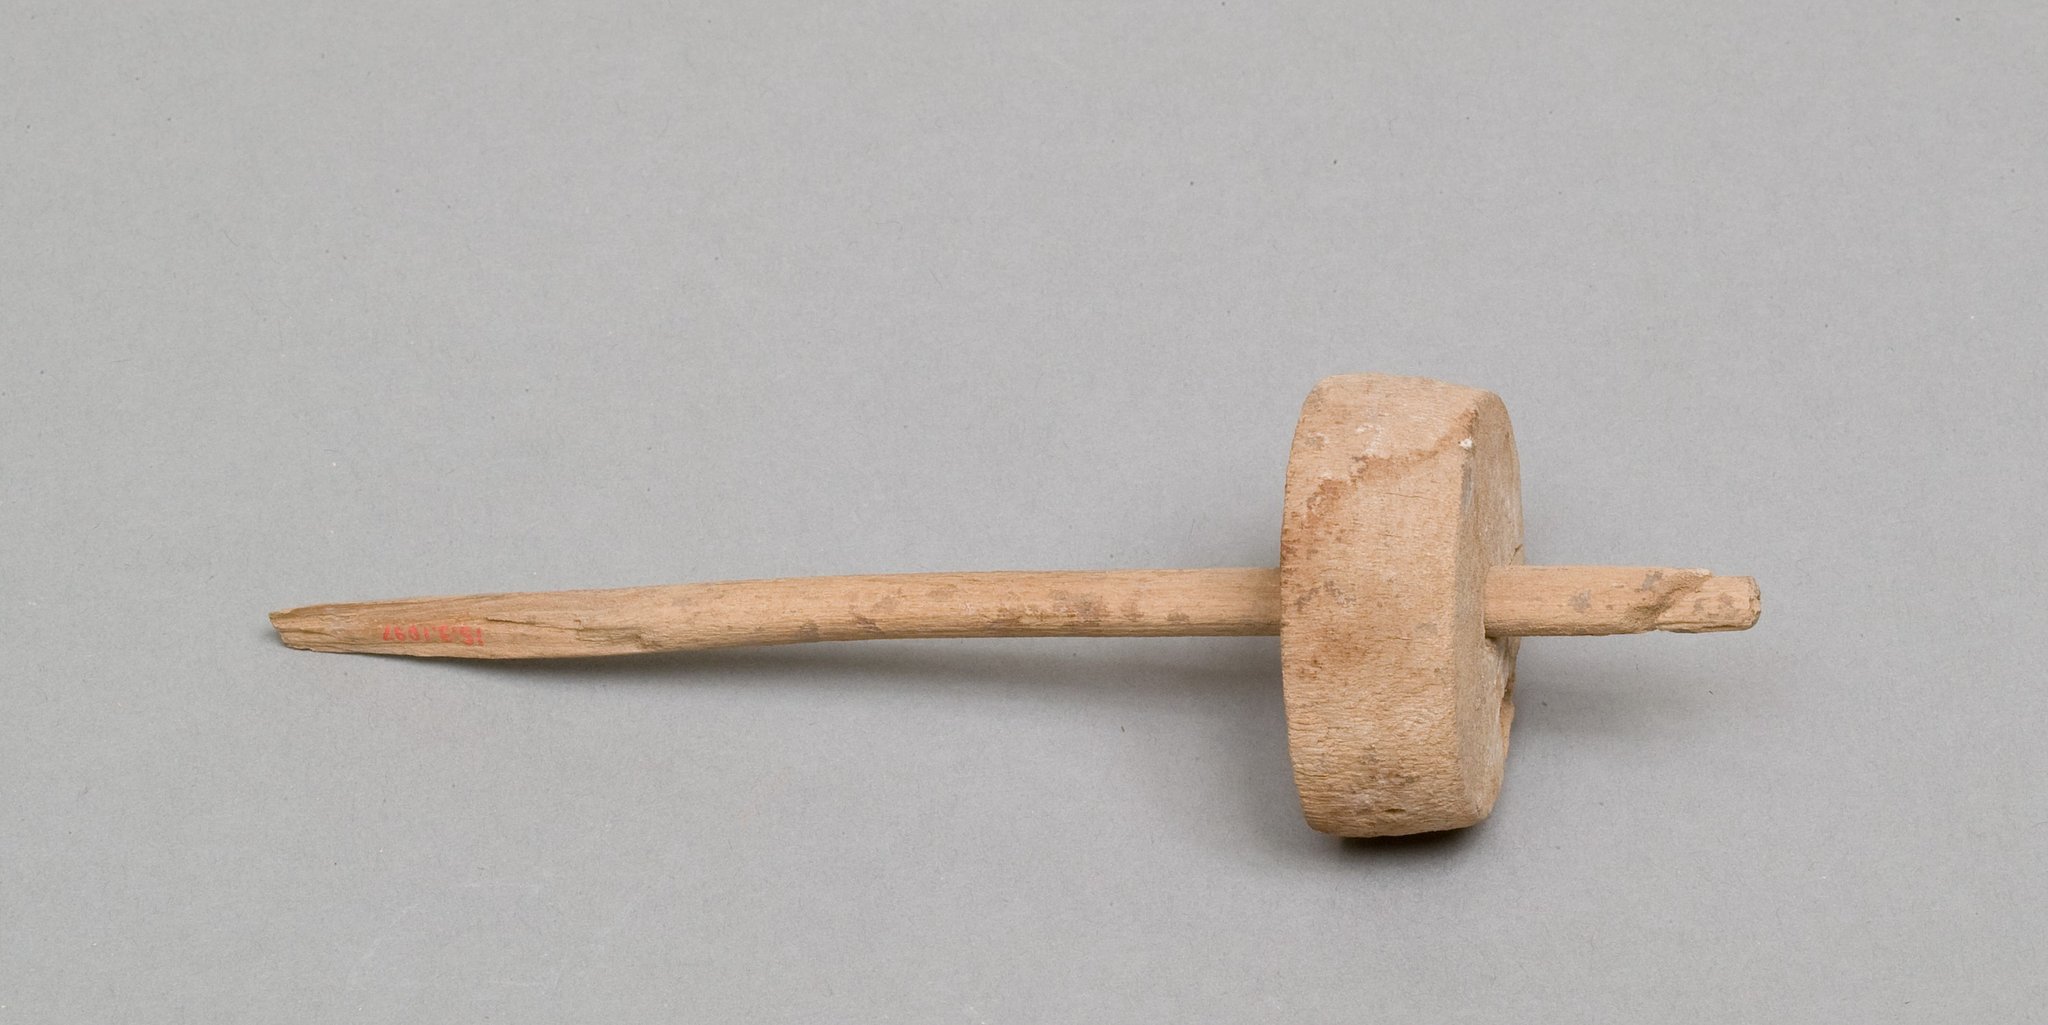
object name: spindle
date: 1295-1070 BCE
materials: wood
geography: egypt